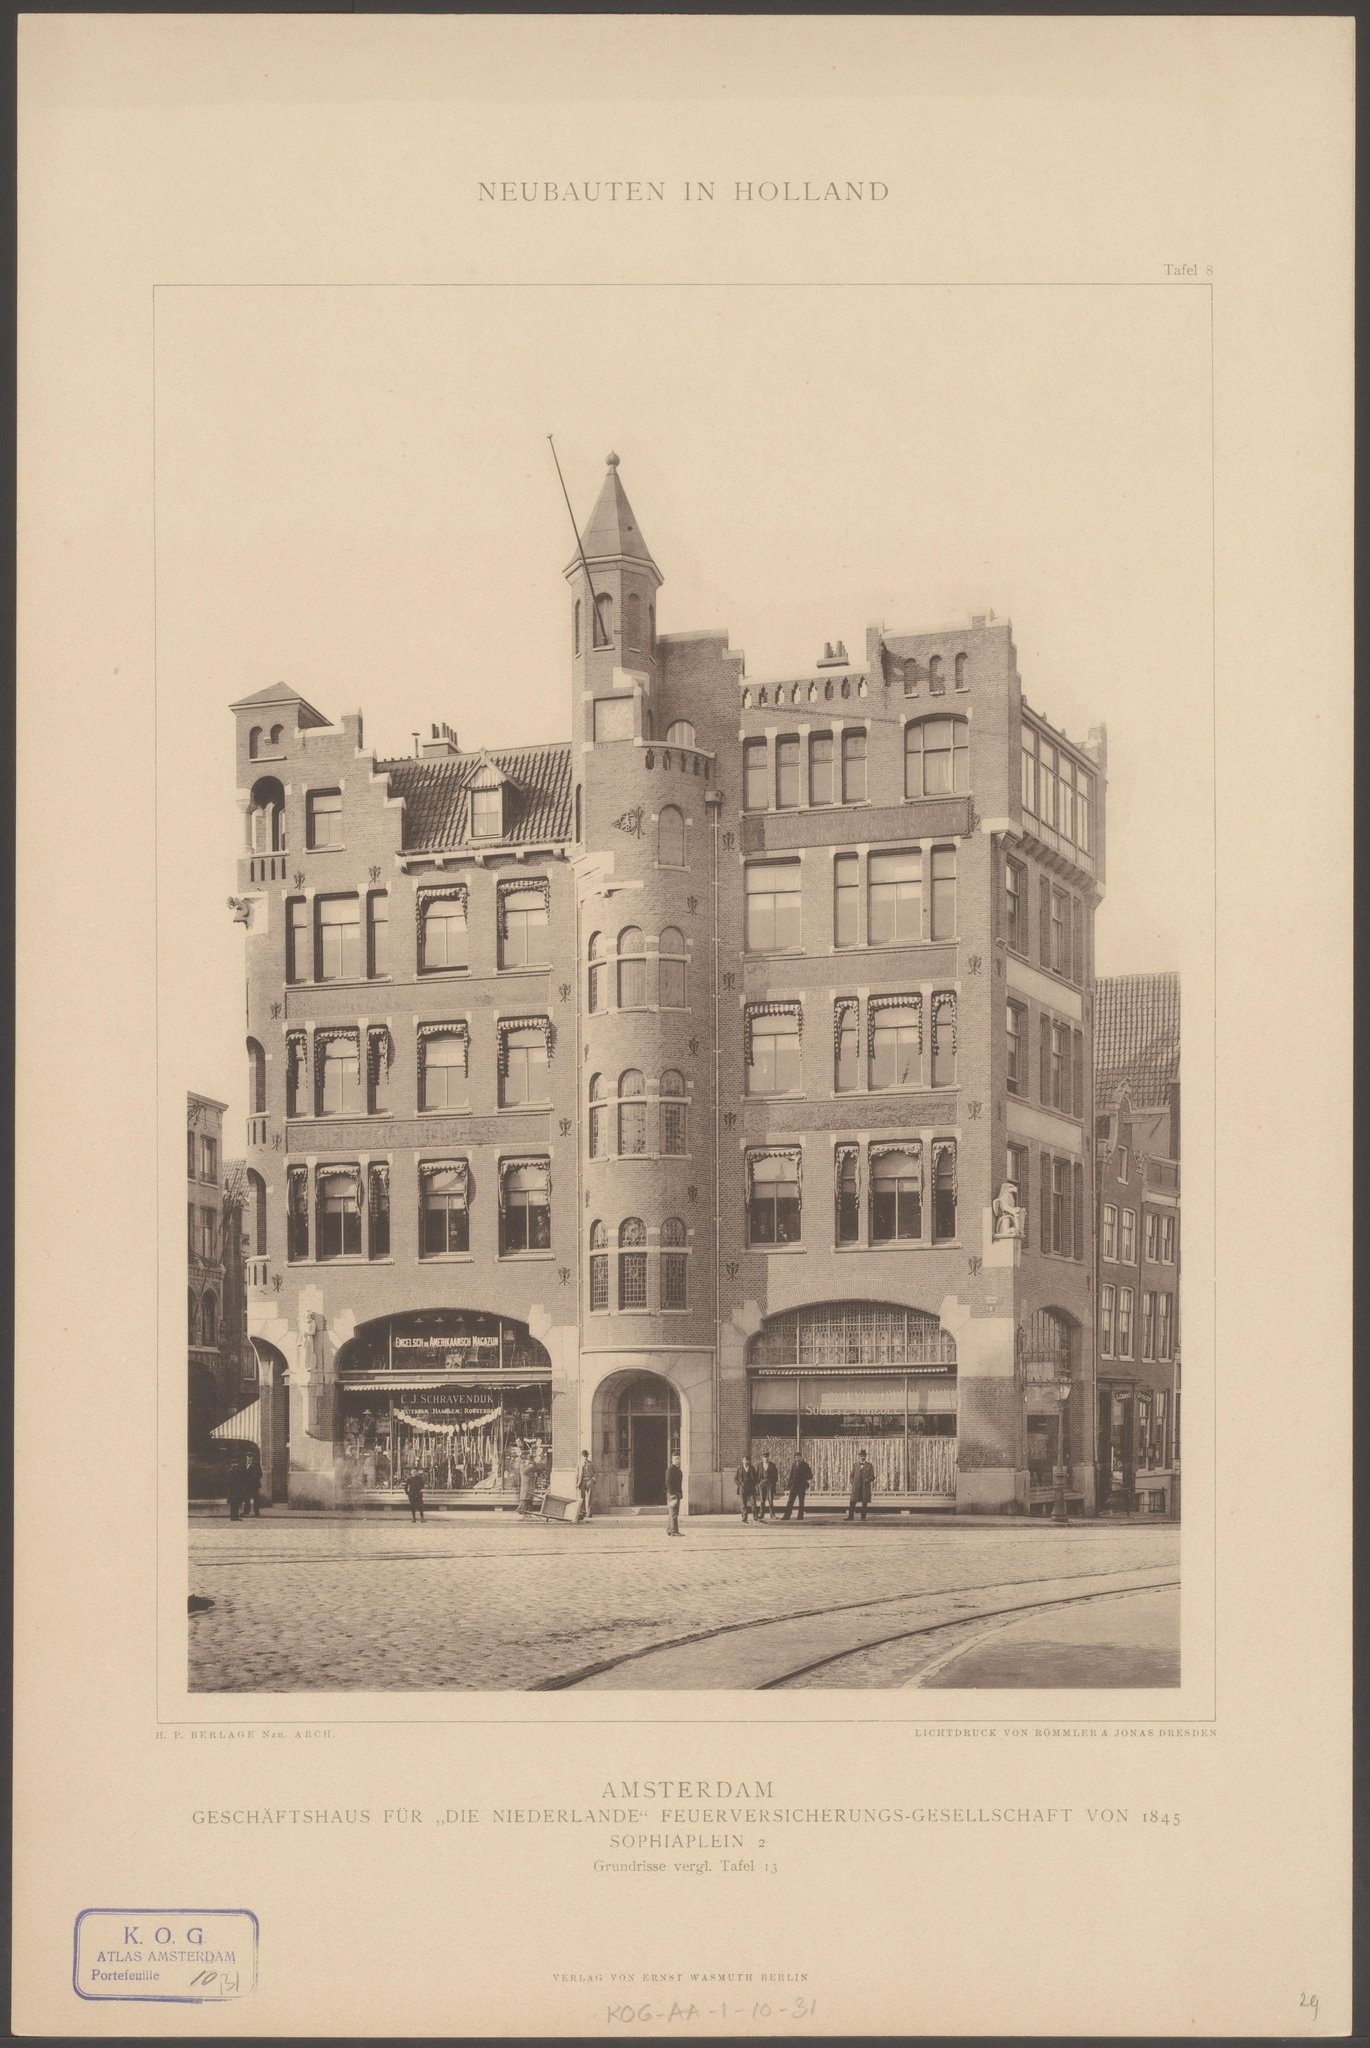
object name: photomechanical print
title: Gezicht op het kantoor van verzekeringsmaatschappij De Nederlanden van 1845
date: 1900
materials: paper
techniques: photograph, letterpress printing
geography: berlin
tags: square, place, circus, etc., insurance, city-view in general; 'veduta', façade (of house or building)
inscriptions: collector's mark: ‘10,31’ Lugt 1641b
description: Onderwerpsrubriek binnen de Atlas Amsterdam: Maagdelievenstraat, Markenplein, Marnixstraat, Martelaarsgracht, Meeuwenlaan, Mennonietenpad, Meijerplein (Jonas Daniël), Mozes en Aäronstraat, Muidergracht, Muntplein. Genummerd rechtsboven: Tafel 8.